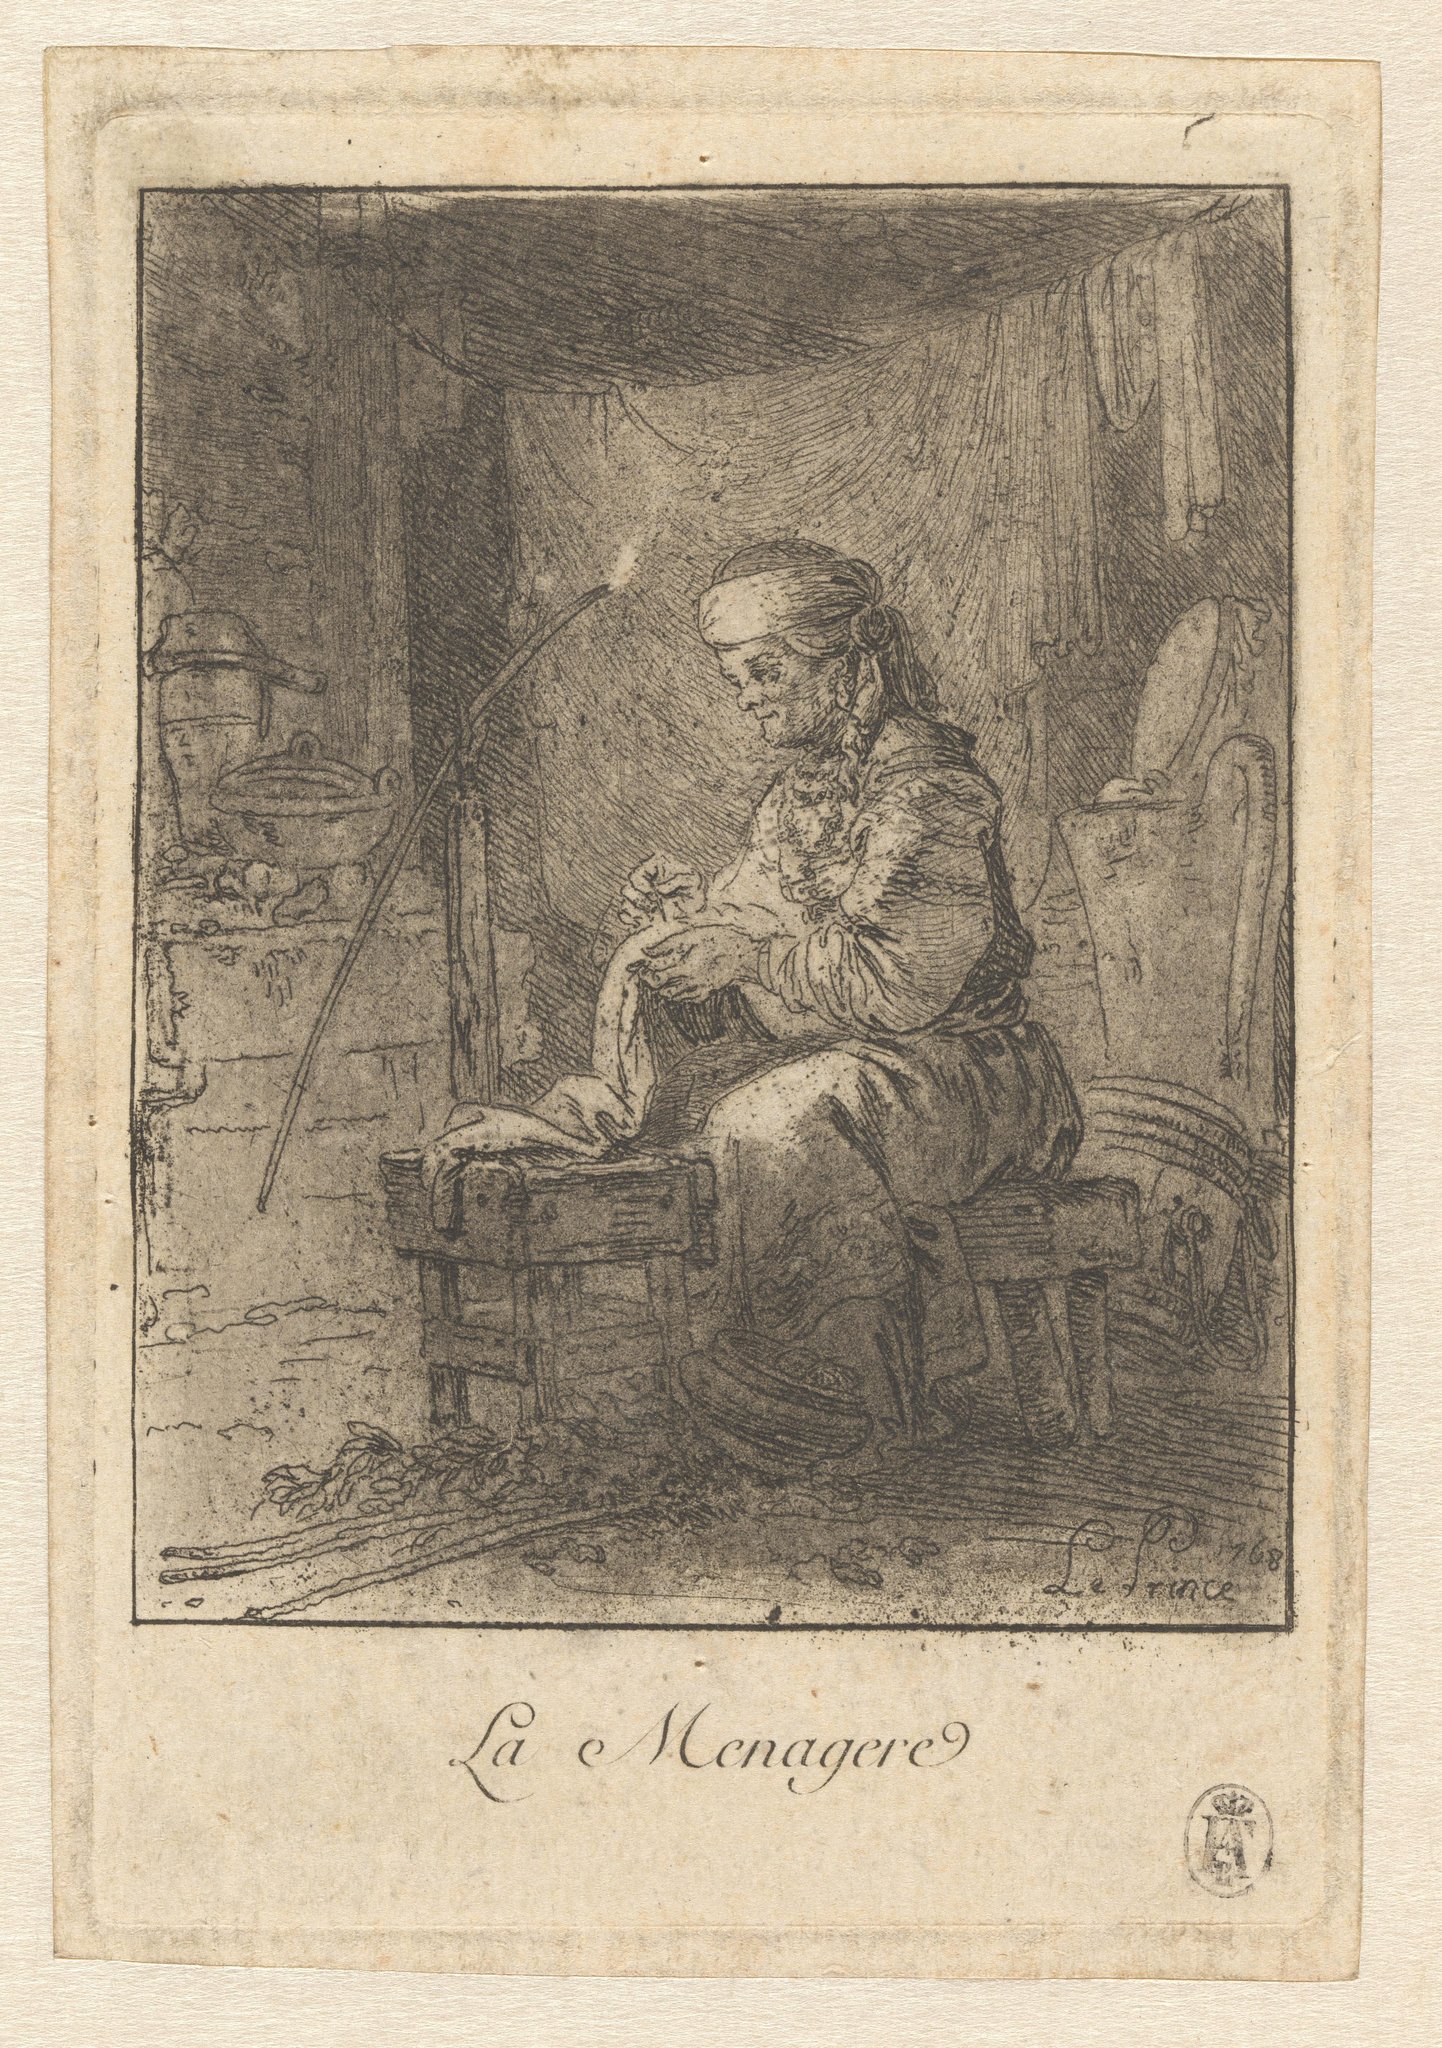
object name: print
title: Boerin met naaiwerk in een interieur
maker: jean baptist leprince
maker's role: draughtsman, print maker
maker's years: 1734-1781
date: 1768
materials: ink, paper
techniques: aquatint, etching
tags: farmers - aa - female farmer, farmer's wife, sewing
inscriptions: collector's mark: Lugt 2228, collector's mark: Lugt 971, collector's mark: Lugt 2760